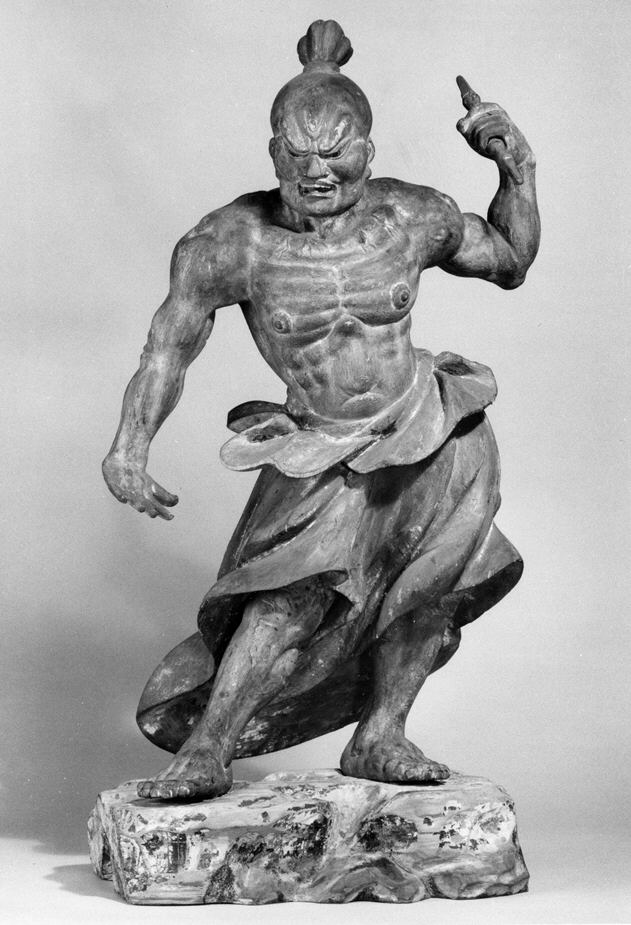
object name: figure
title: Temple Guardian (Nio, one of a pair)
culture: japanese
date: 1301-1333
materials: wood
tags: men